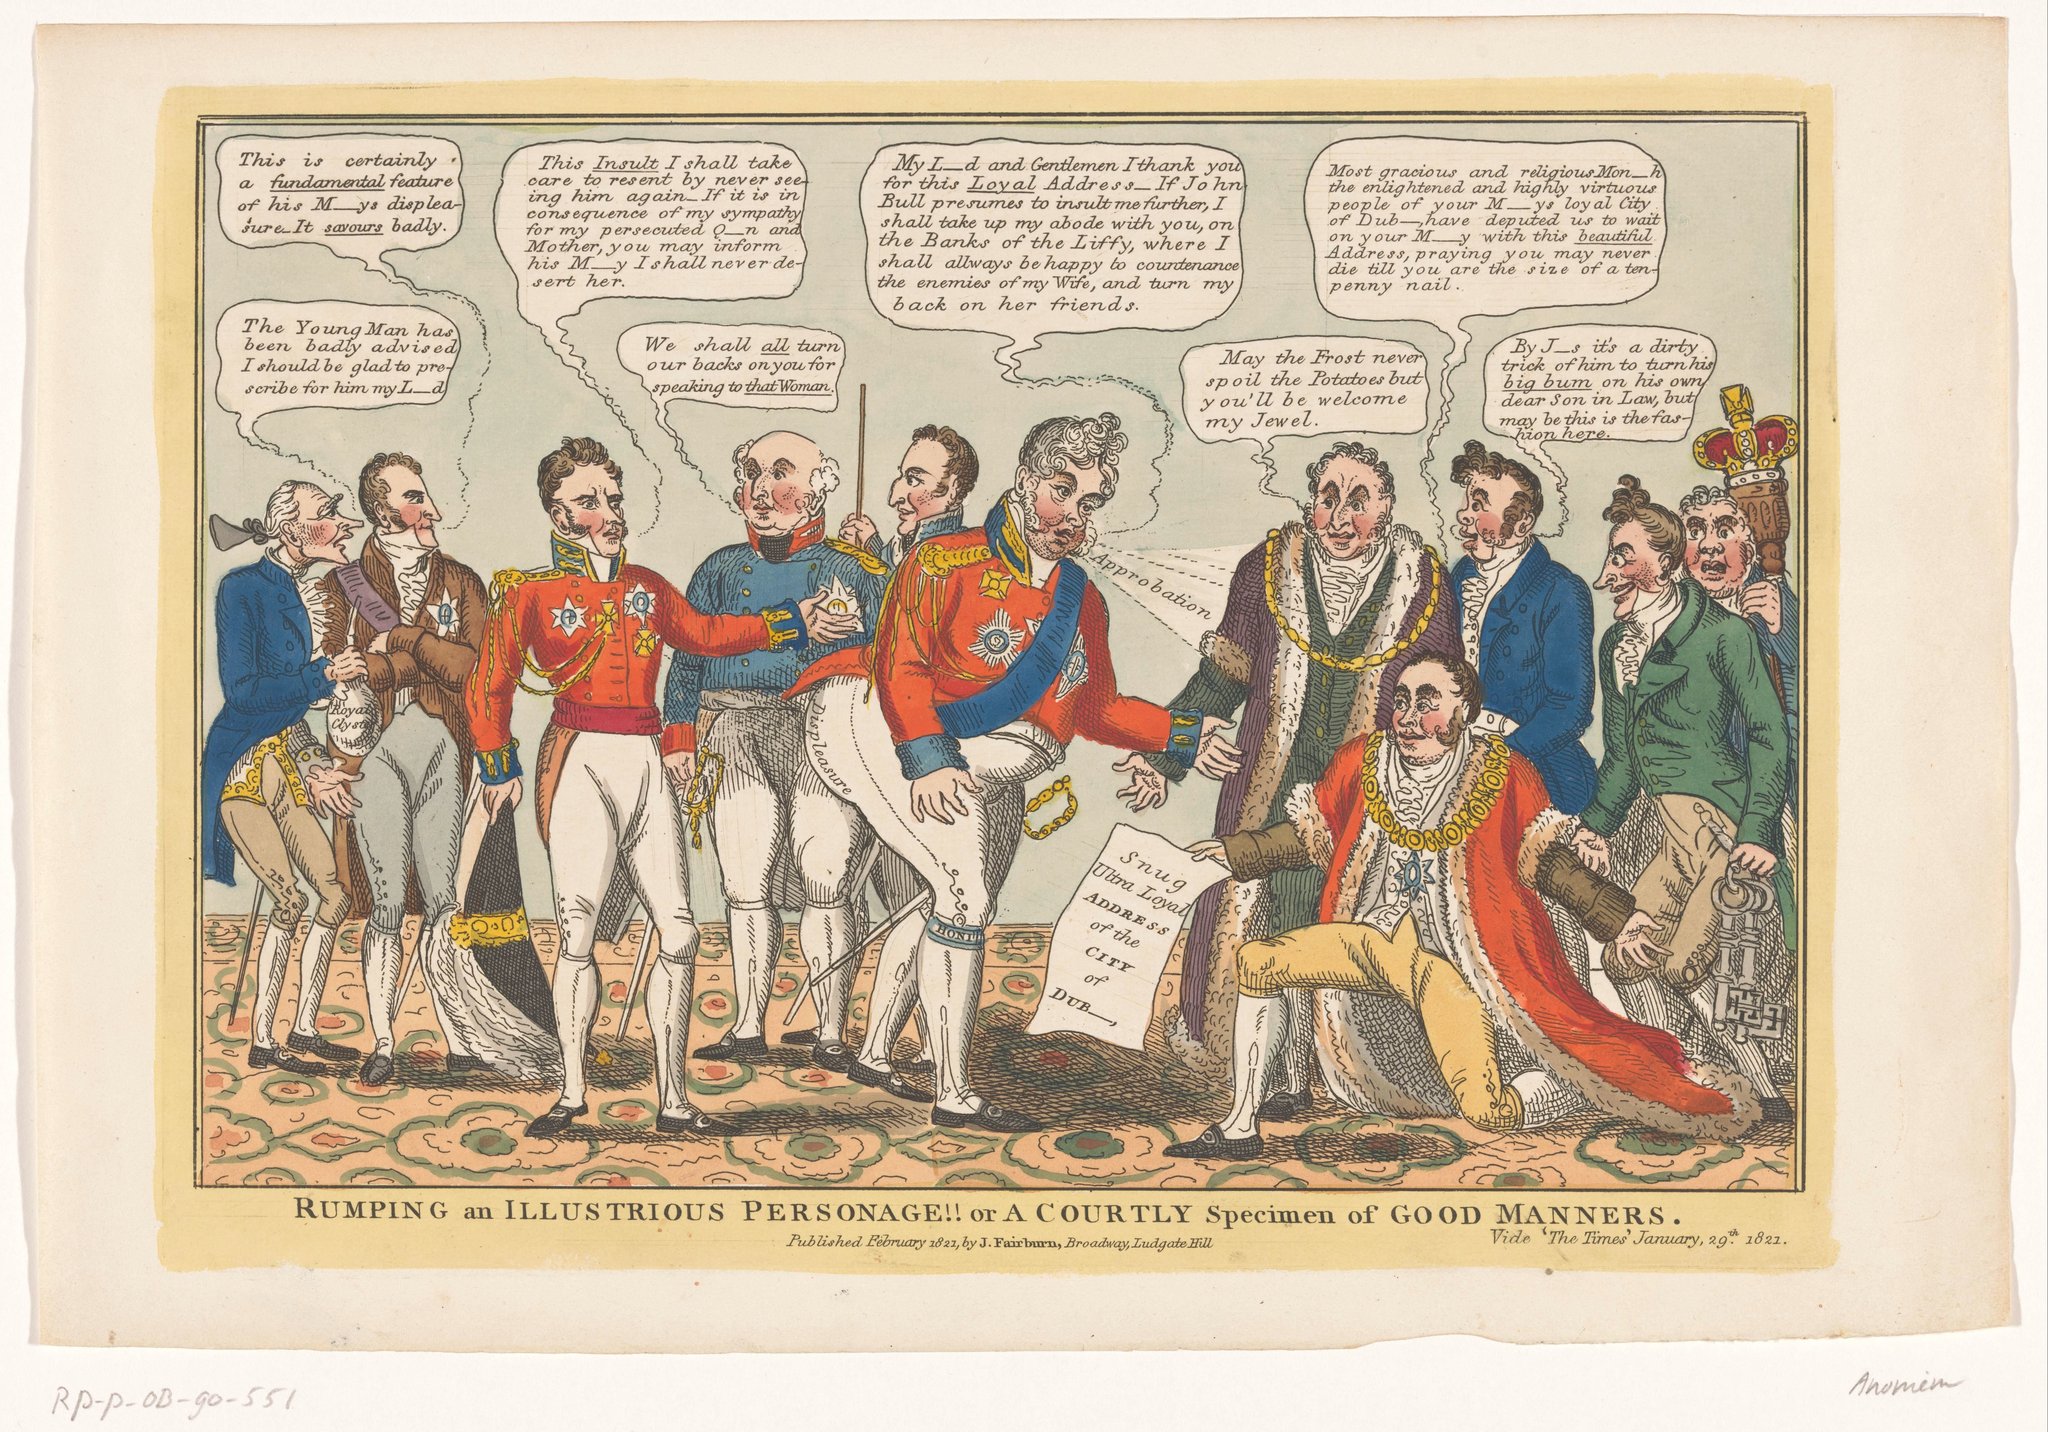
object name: print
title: Rumping an illustrious personage!! or a courtly specimen of good manners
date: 1802-1821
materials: paper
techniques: etching, hand coloring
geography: london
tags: george iv (koning van het verenigd koninkrijk), diplomacy, diplomat, political caricatures and satires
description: Spotprent met de Engelse koning George IV die in 1821 gezanten van de Ierse stad Dublin ontvangt.